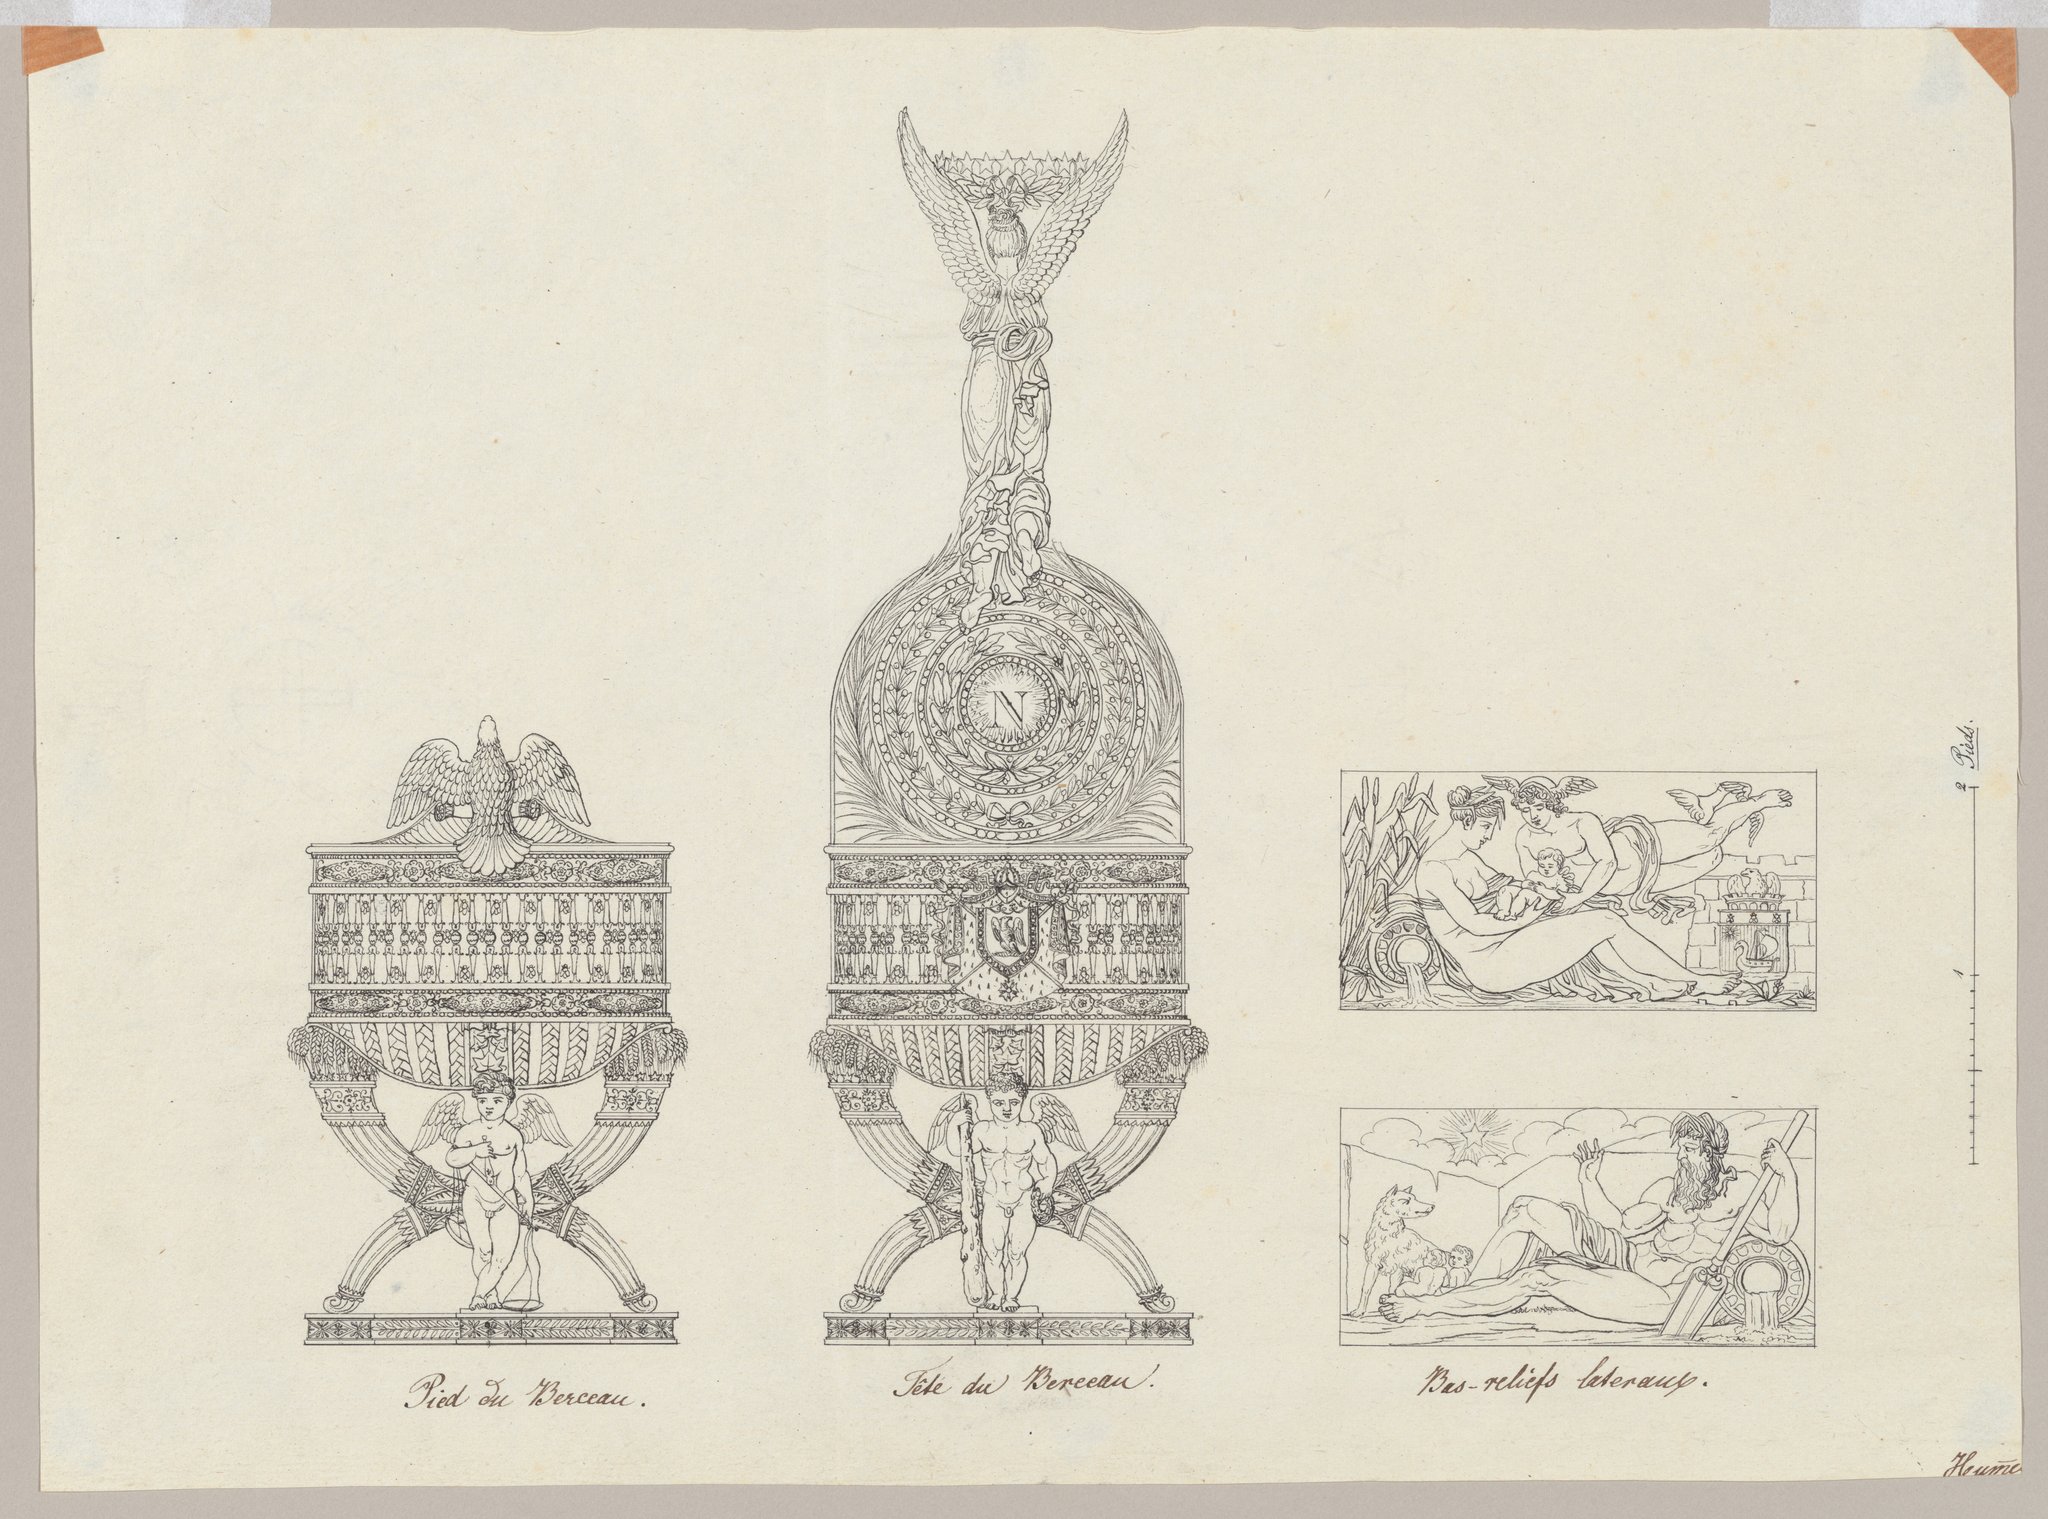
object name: print ornament architecture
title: Elevations and Bas-reliefs of The Cradle of His Majesty the King of Rome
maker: adrien louis marie cavelier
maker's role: artist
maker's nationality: french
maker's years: 1785-1867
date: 1810-1811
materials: ink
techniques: pen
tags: cradles